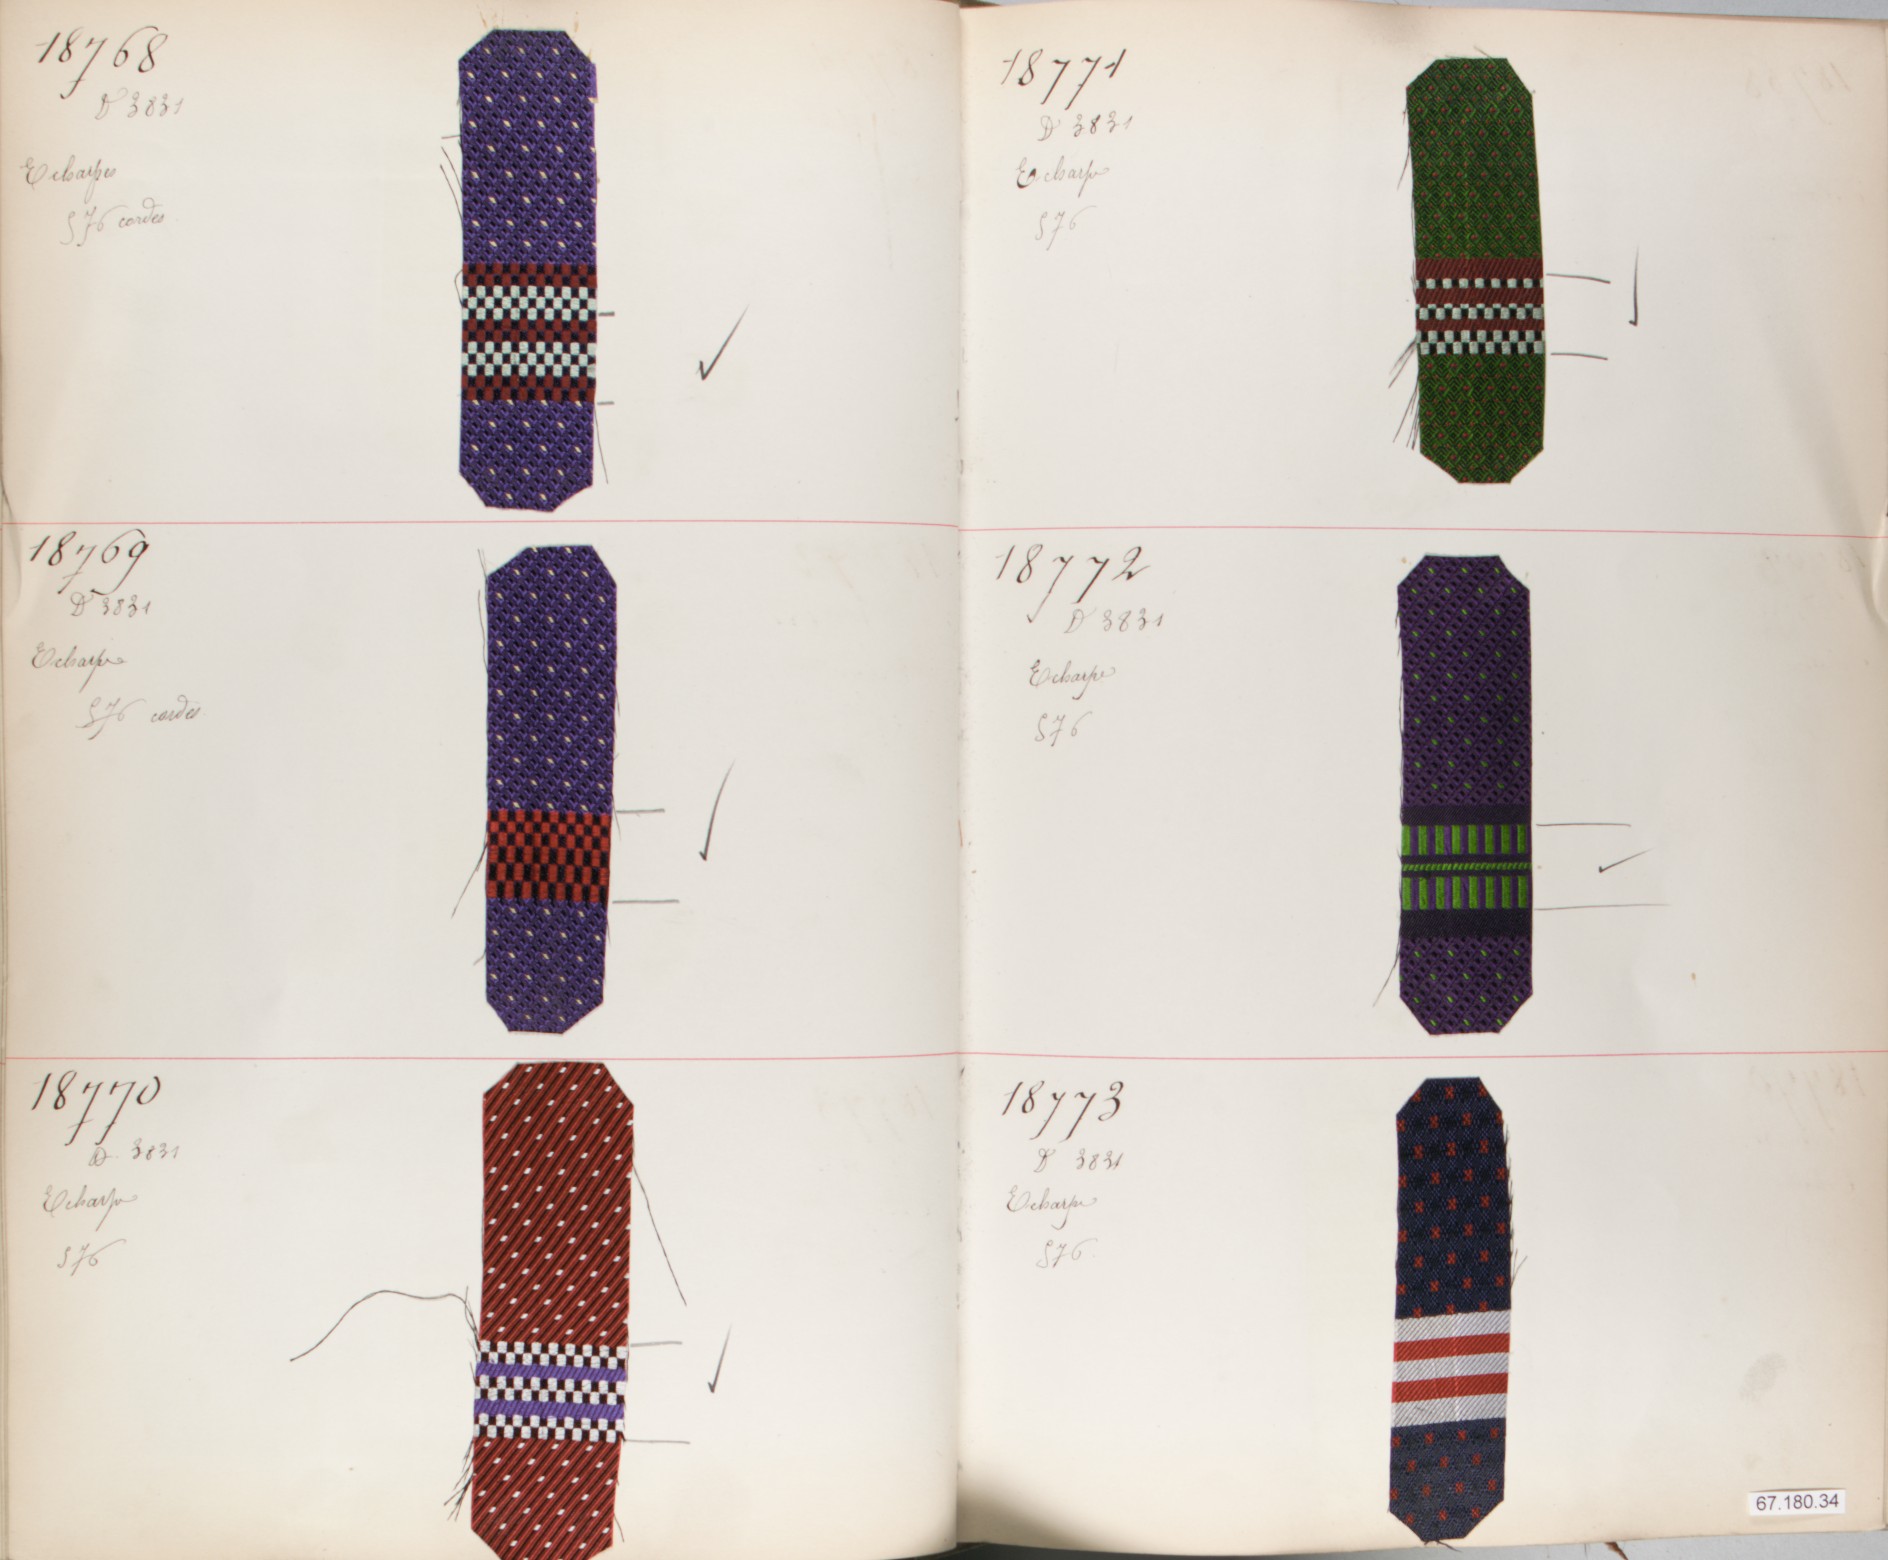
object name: sample book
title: Textile Sample Book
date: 1801-1850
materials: cotton, silk